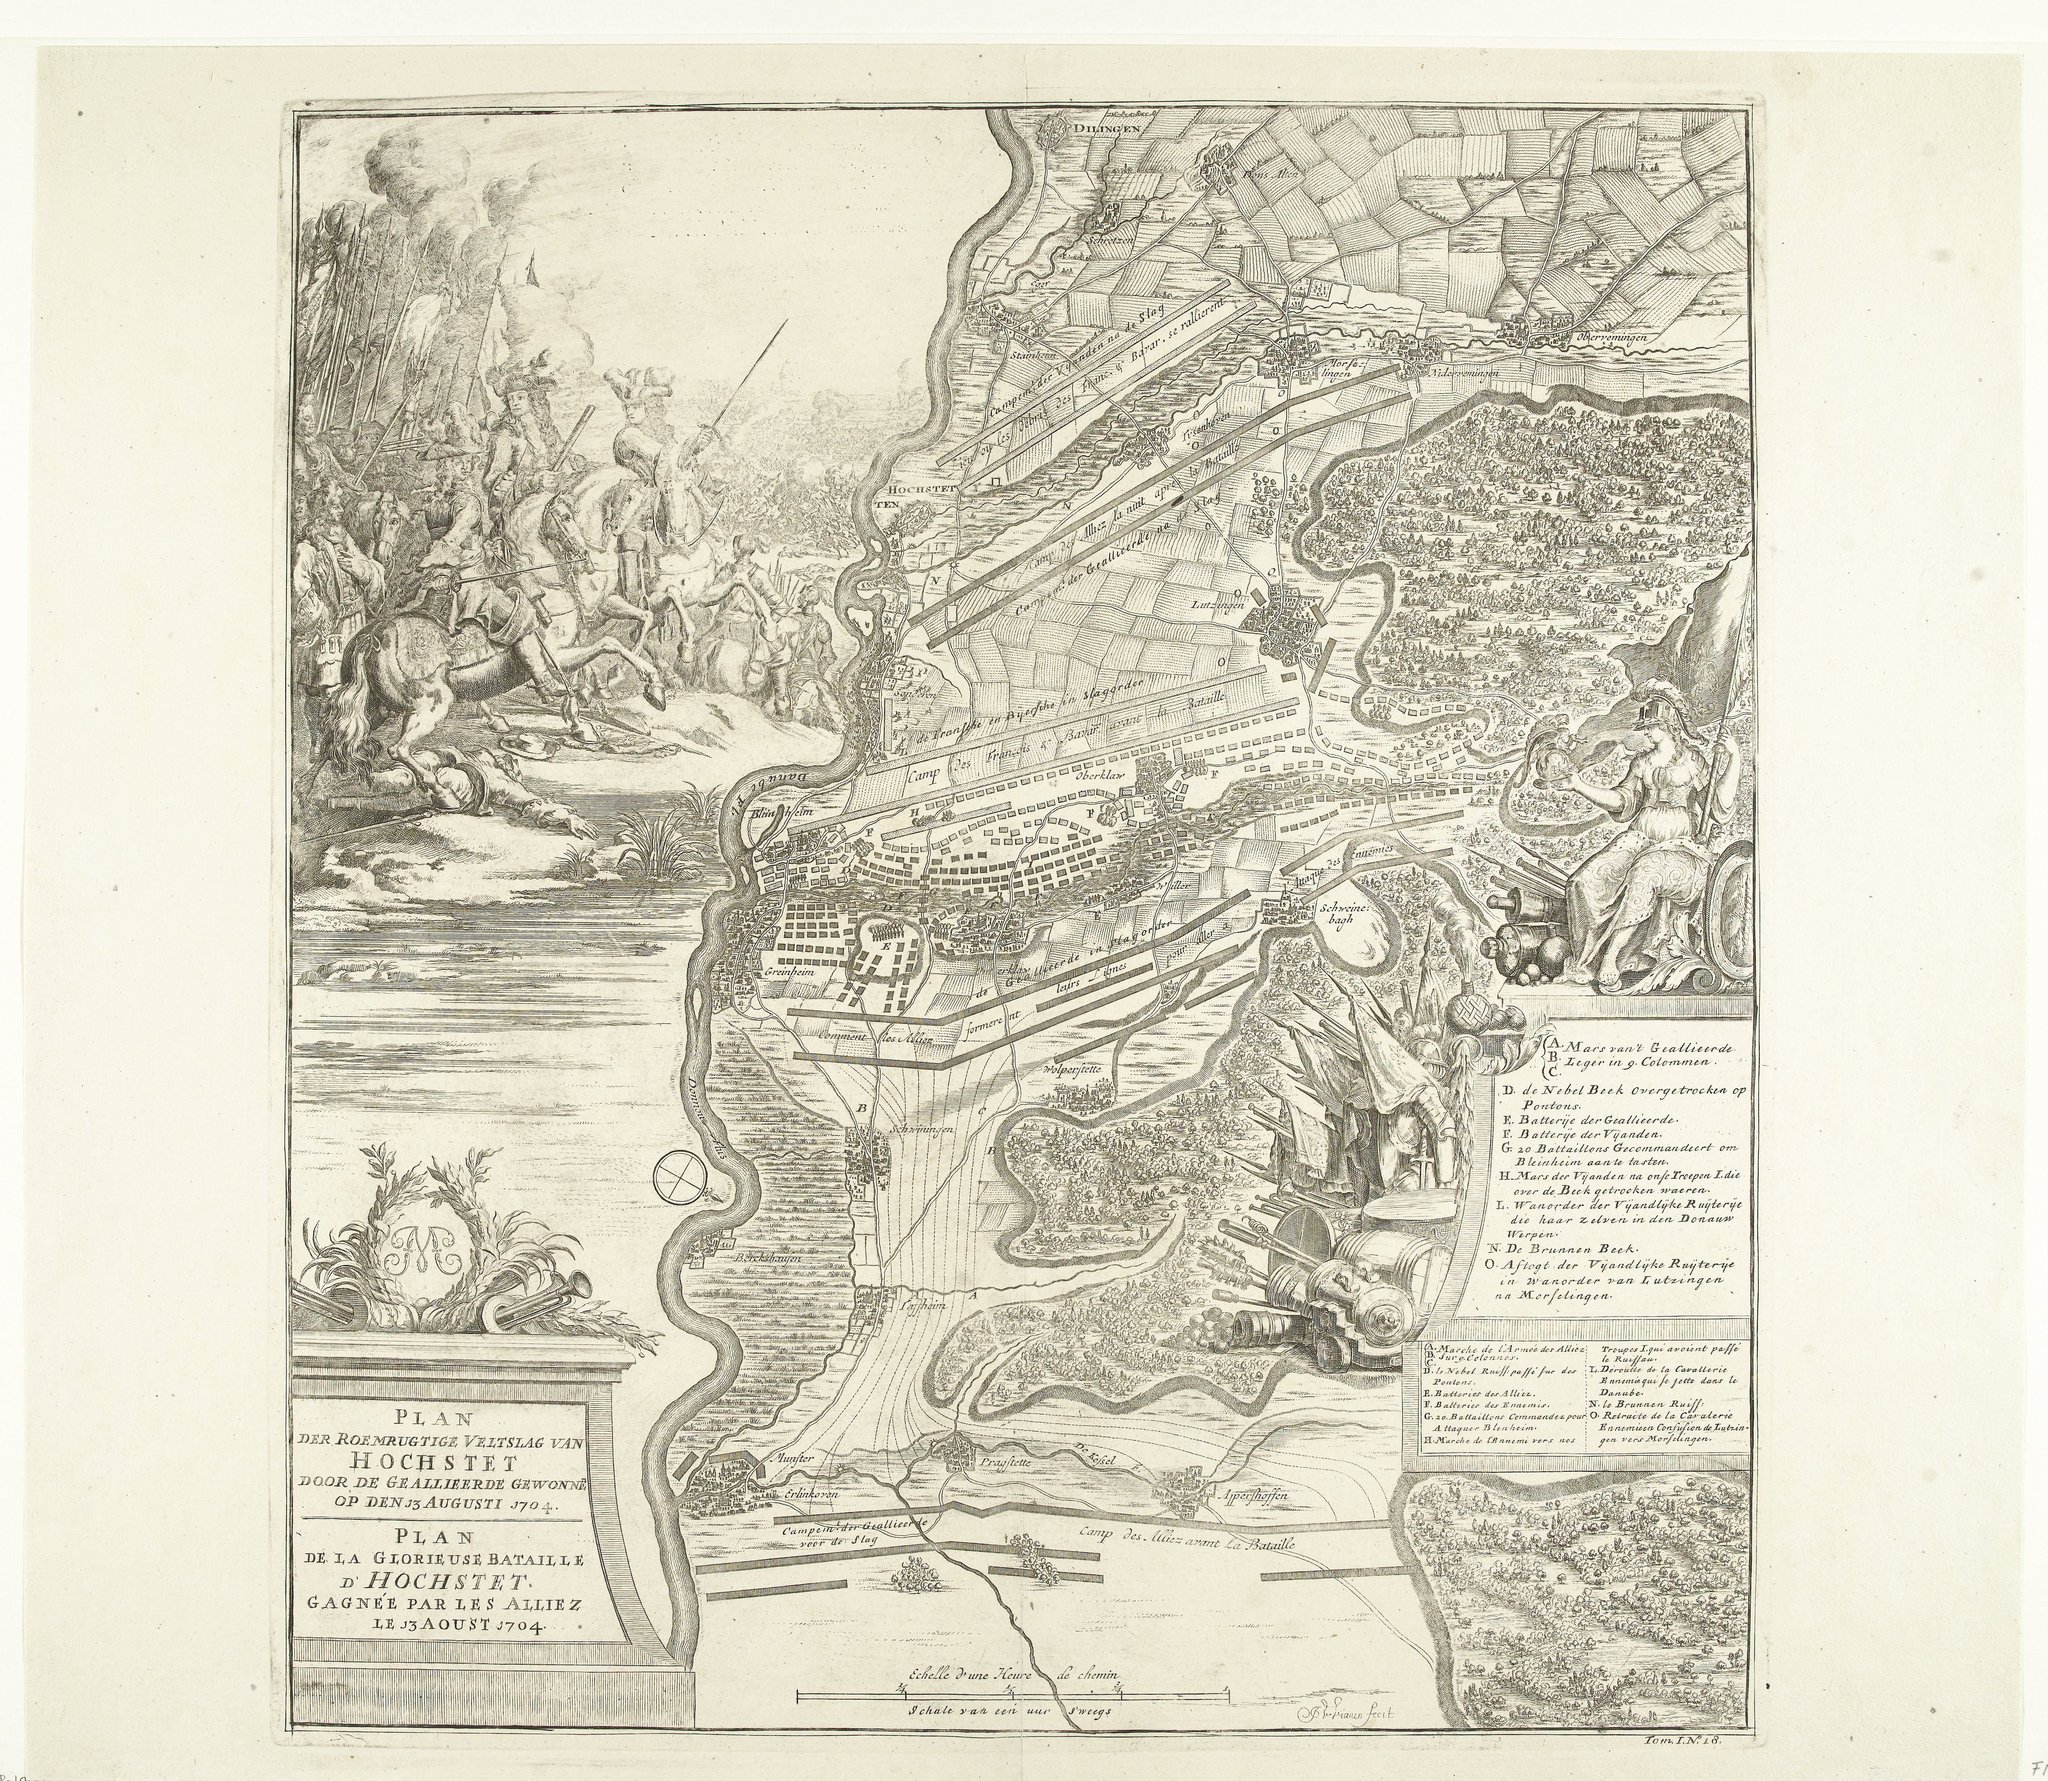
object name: print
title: Plan der roemrugtige veltslag van Hochstet door de geallieerde gewonne[n] op den 13 augusti 1704 / Plan de la glorieuse bataille d'Hochstet, gagnée par les alliez le 13 aoust 1704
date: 1704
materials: paper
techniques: engraving, etching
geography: northern netherlands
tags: frederik i (koning van zweden), paris, eugenius van savoye, john churchill (1e hertog van marlborough), maps of separate countries or regions, battle (+ land forces)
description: Kaart van de slag bij Höchstädt (slag bij Blenheim) met een overwinning van de Geallieerden op de Fransen, 13 augustus 1704. Linksboven de drie bevelhebbers van de Geallieerden: hertog van Marlborough, prins Eugenius van Savoye en de erfprins van Hessen Kassel (Frederik I), rechts een cartouche met de titel versierd met wapens en vaandels. Gemerkt rechtsonder: Tom. I. No. 18.